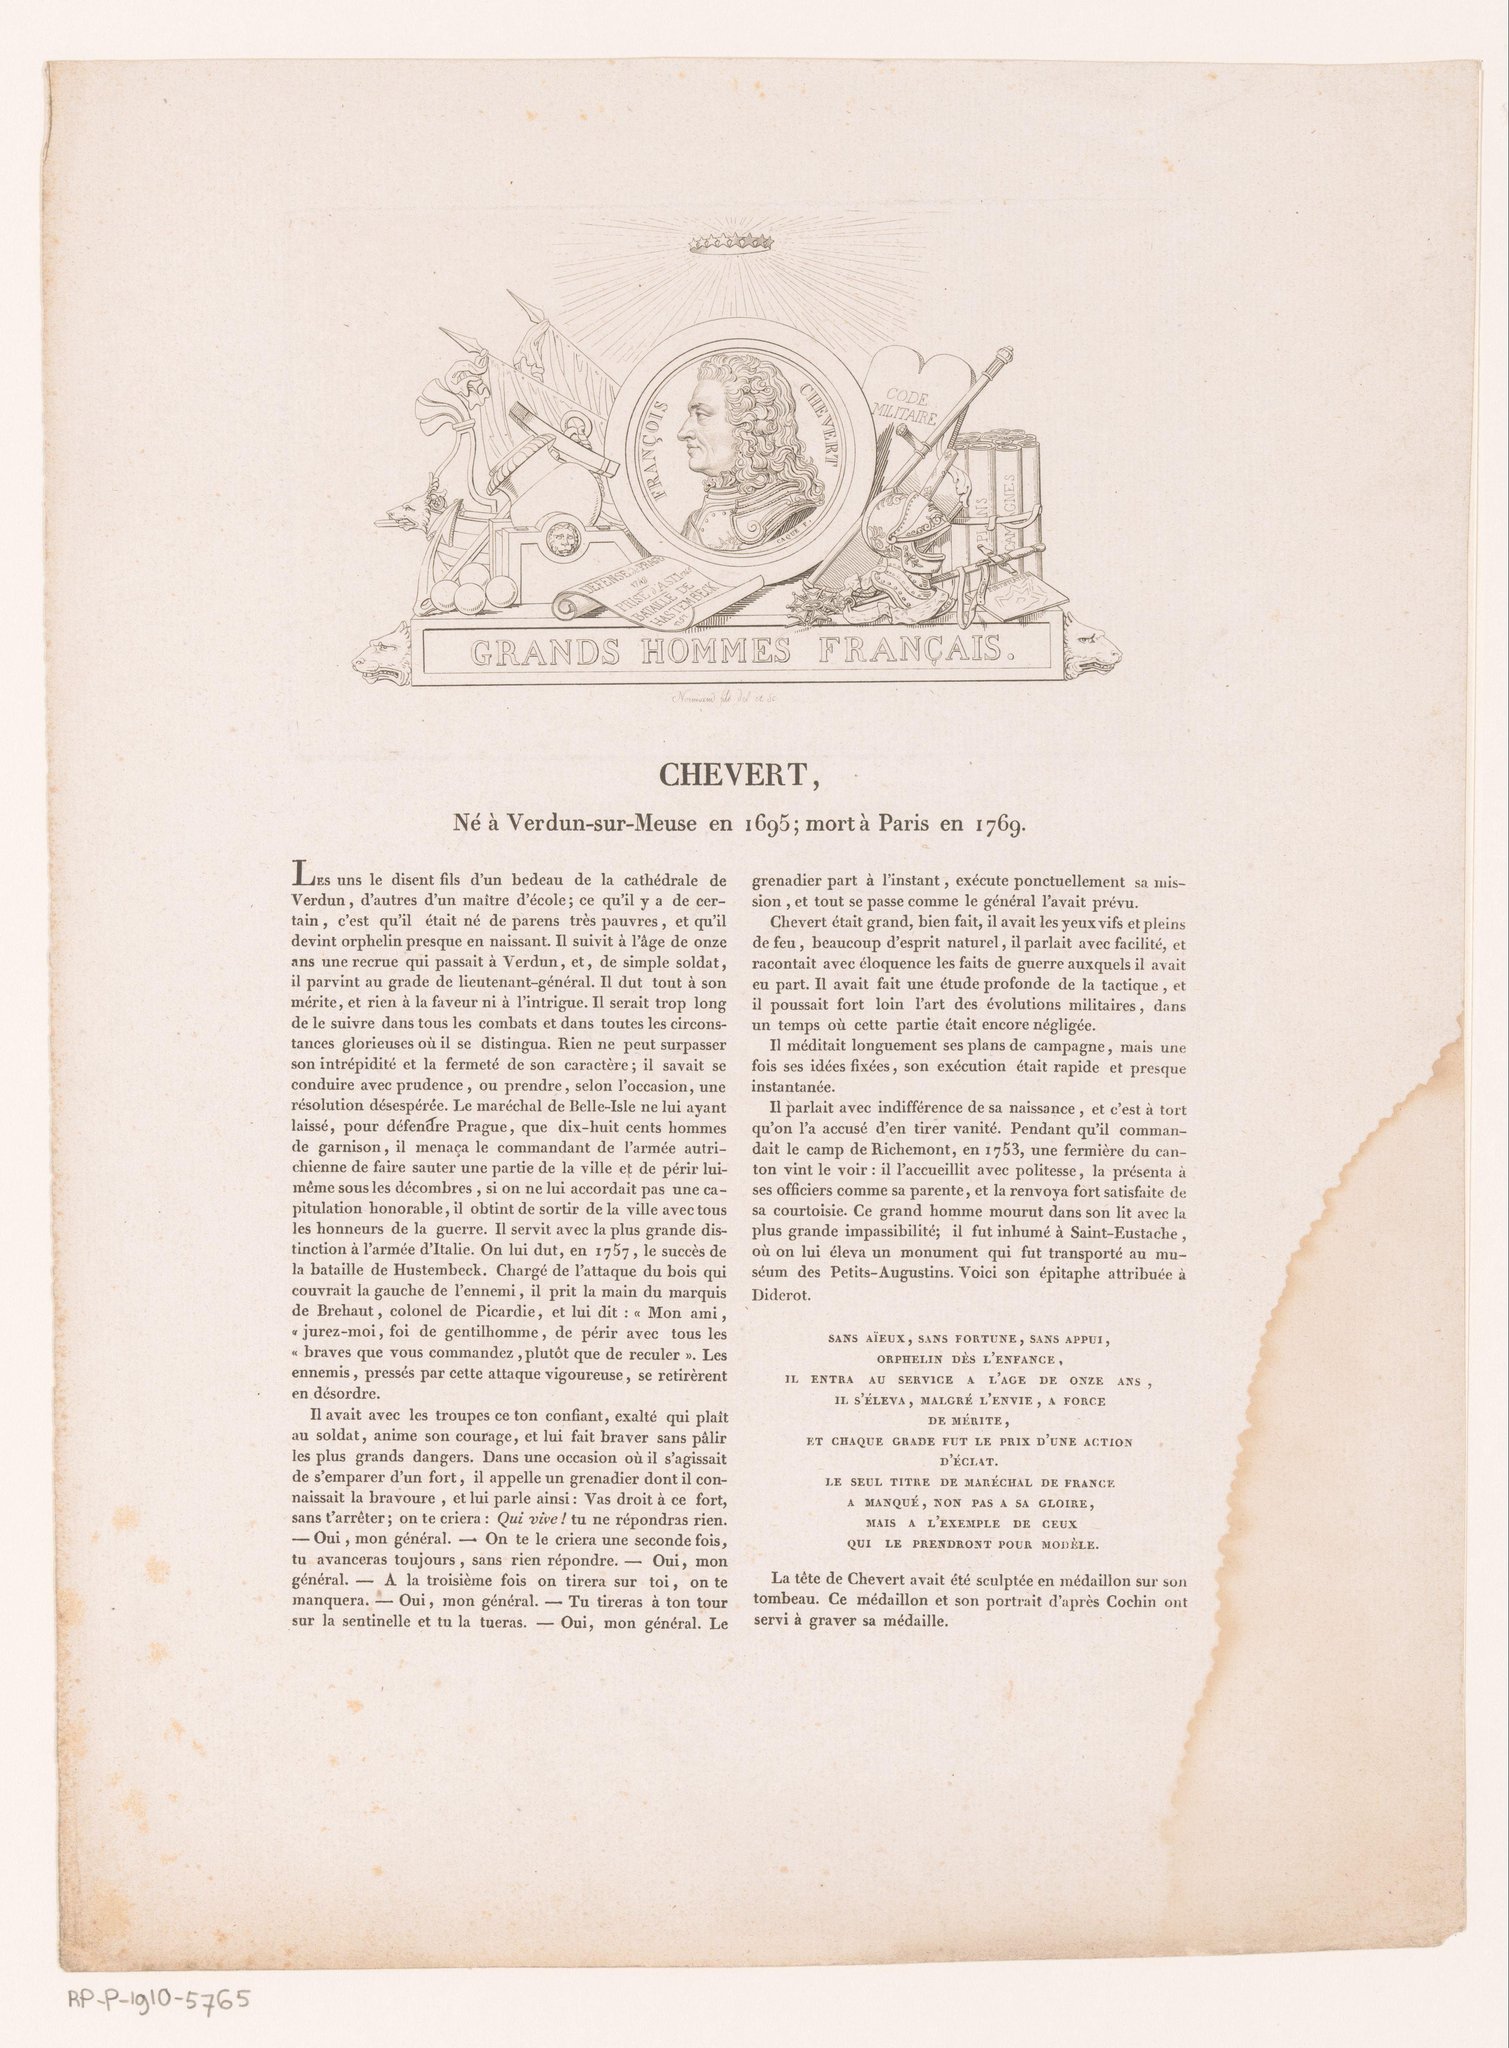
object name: print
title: Galerie métallique des grands hommes français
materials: paper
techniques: etching, letterpress printing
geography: paris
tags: commander-in-chief, general, marshal, historical persons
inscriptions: collector's mark: Lugt 2228